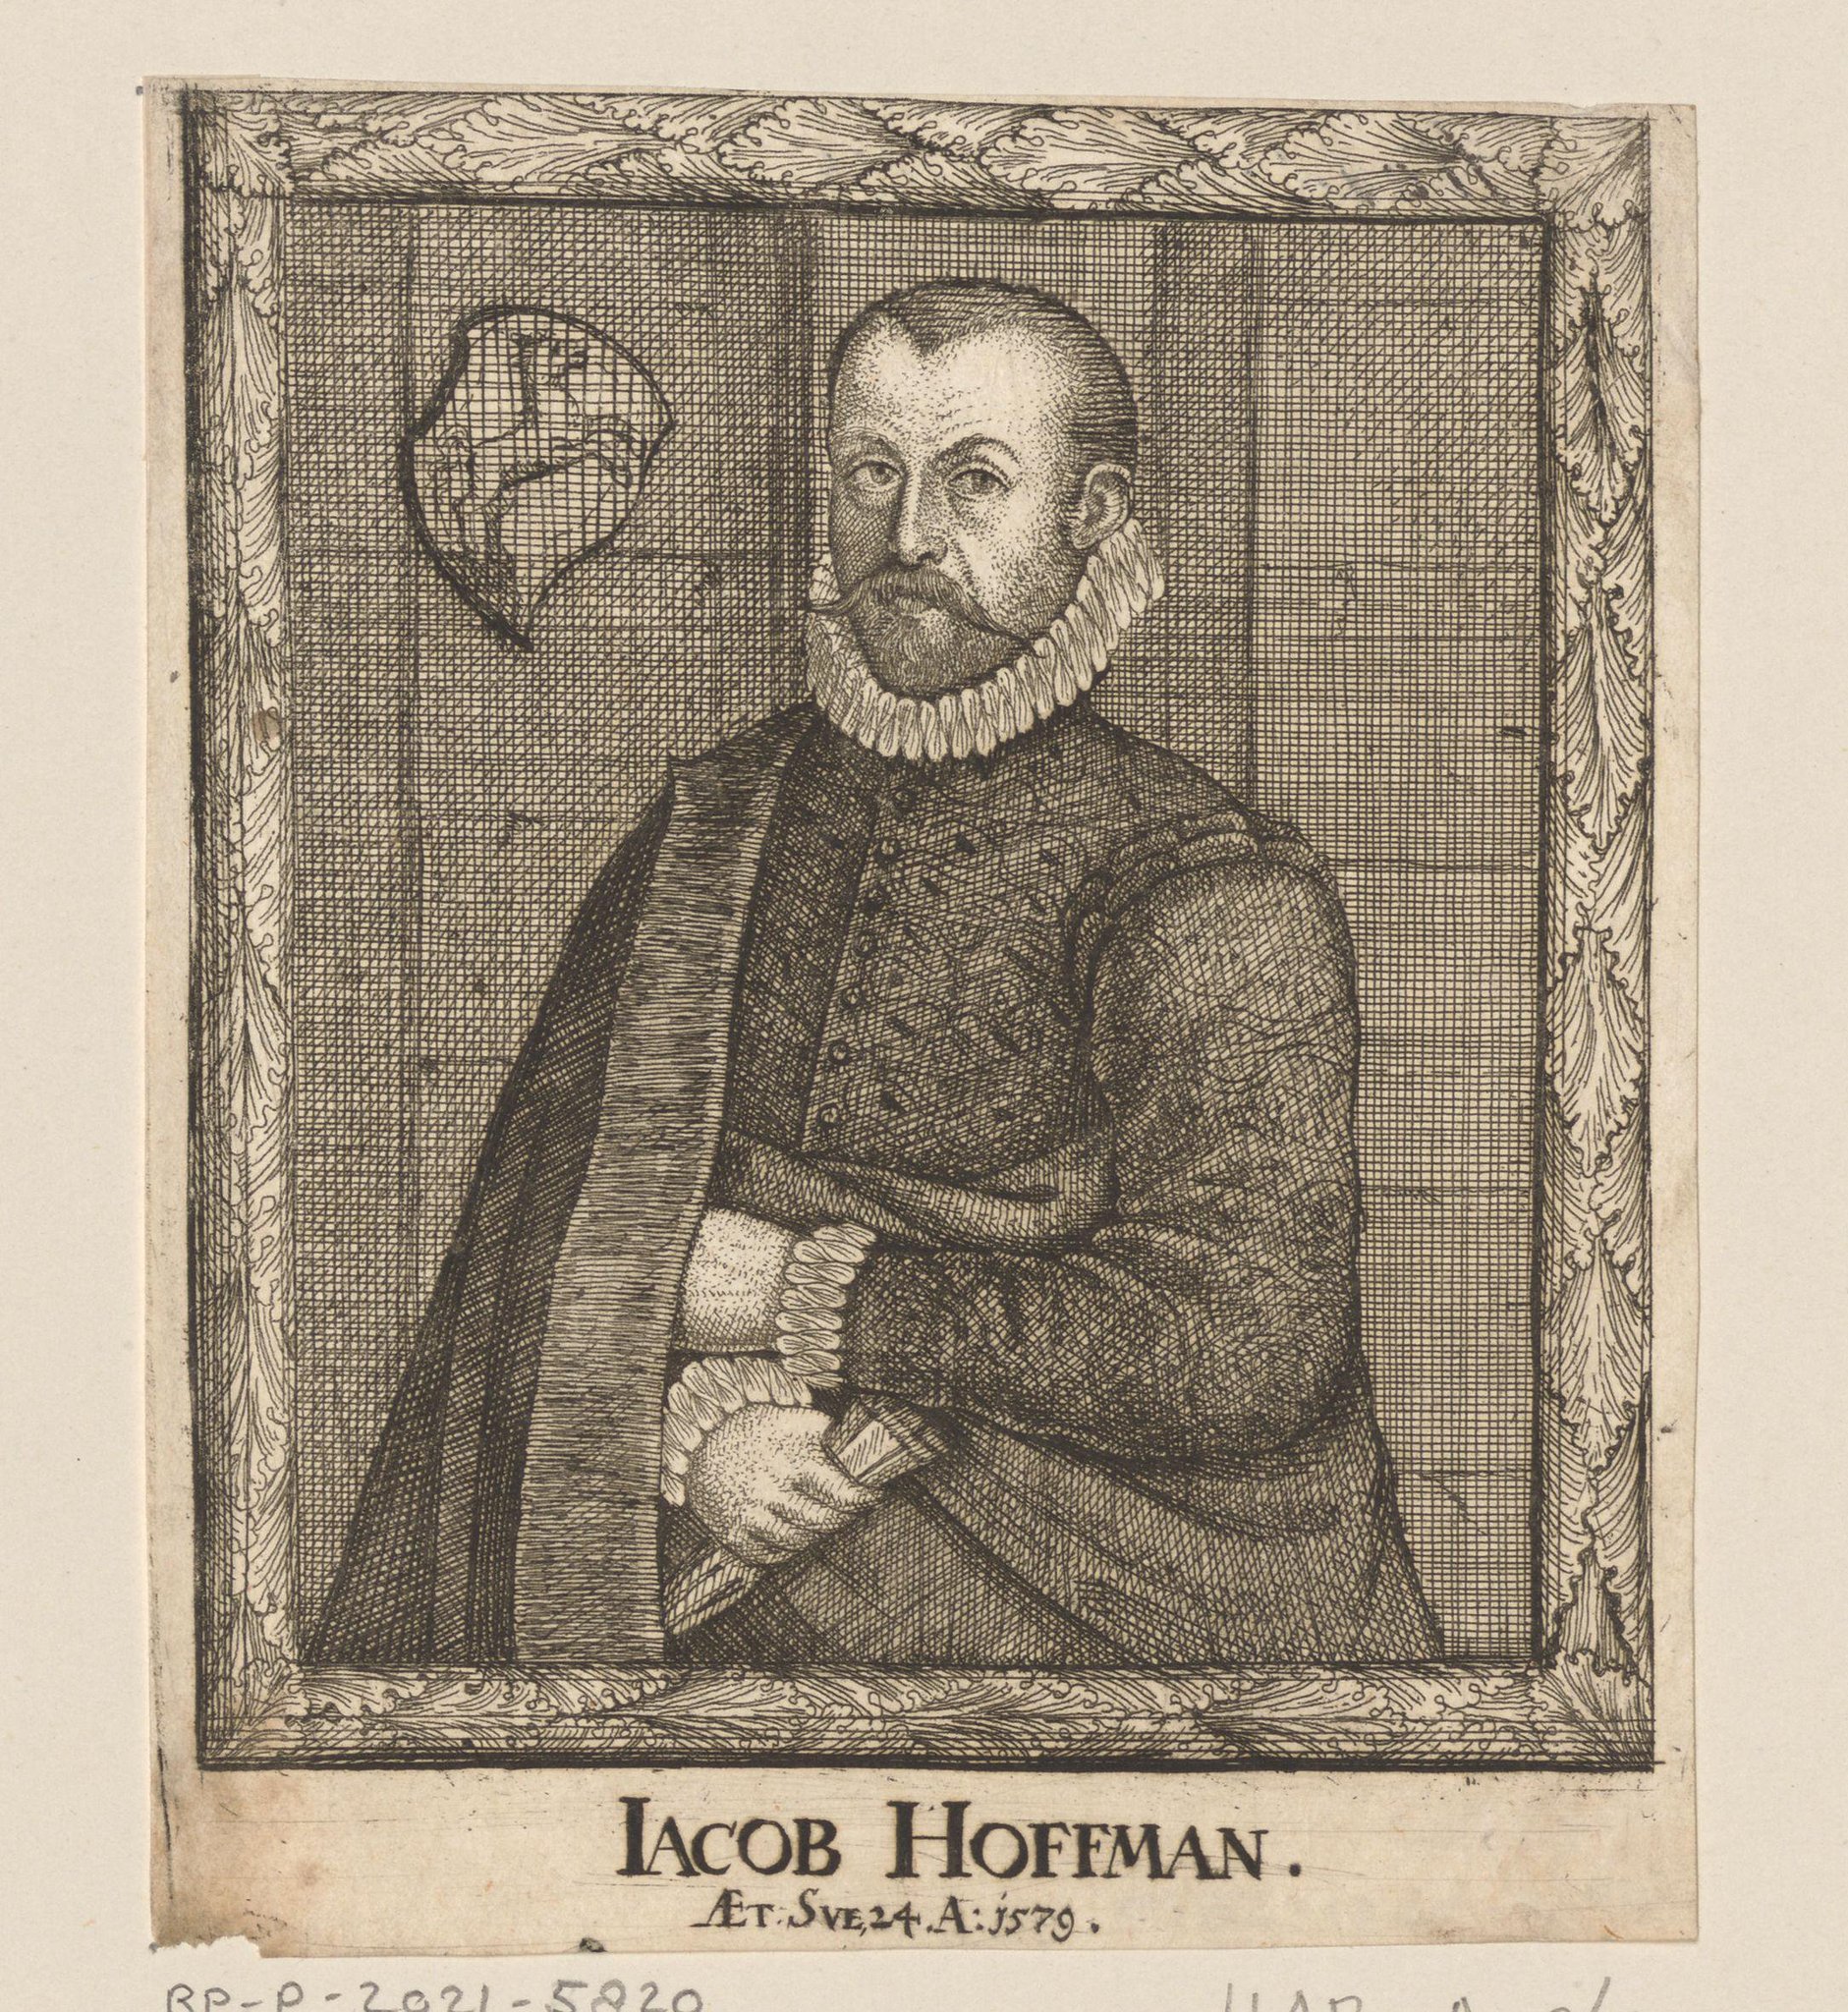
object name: print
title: Portret van Jacob Hoffmann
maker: Anonymous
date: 1579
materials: paper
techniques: etching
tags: historical persons, armorial bearing, heraldry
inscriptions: inscription: ‘Hoffman 1238’